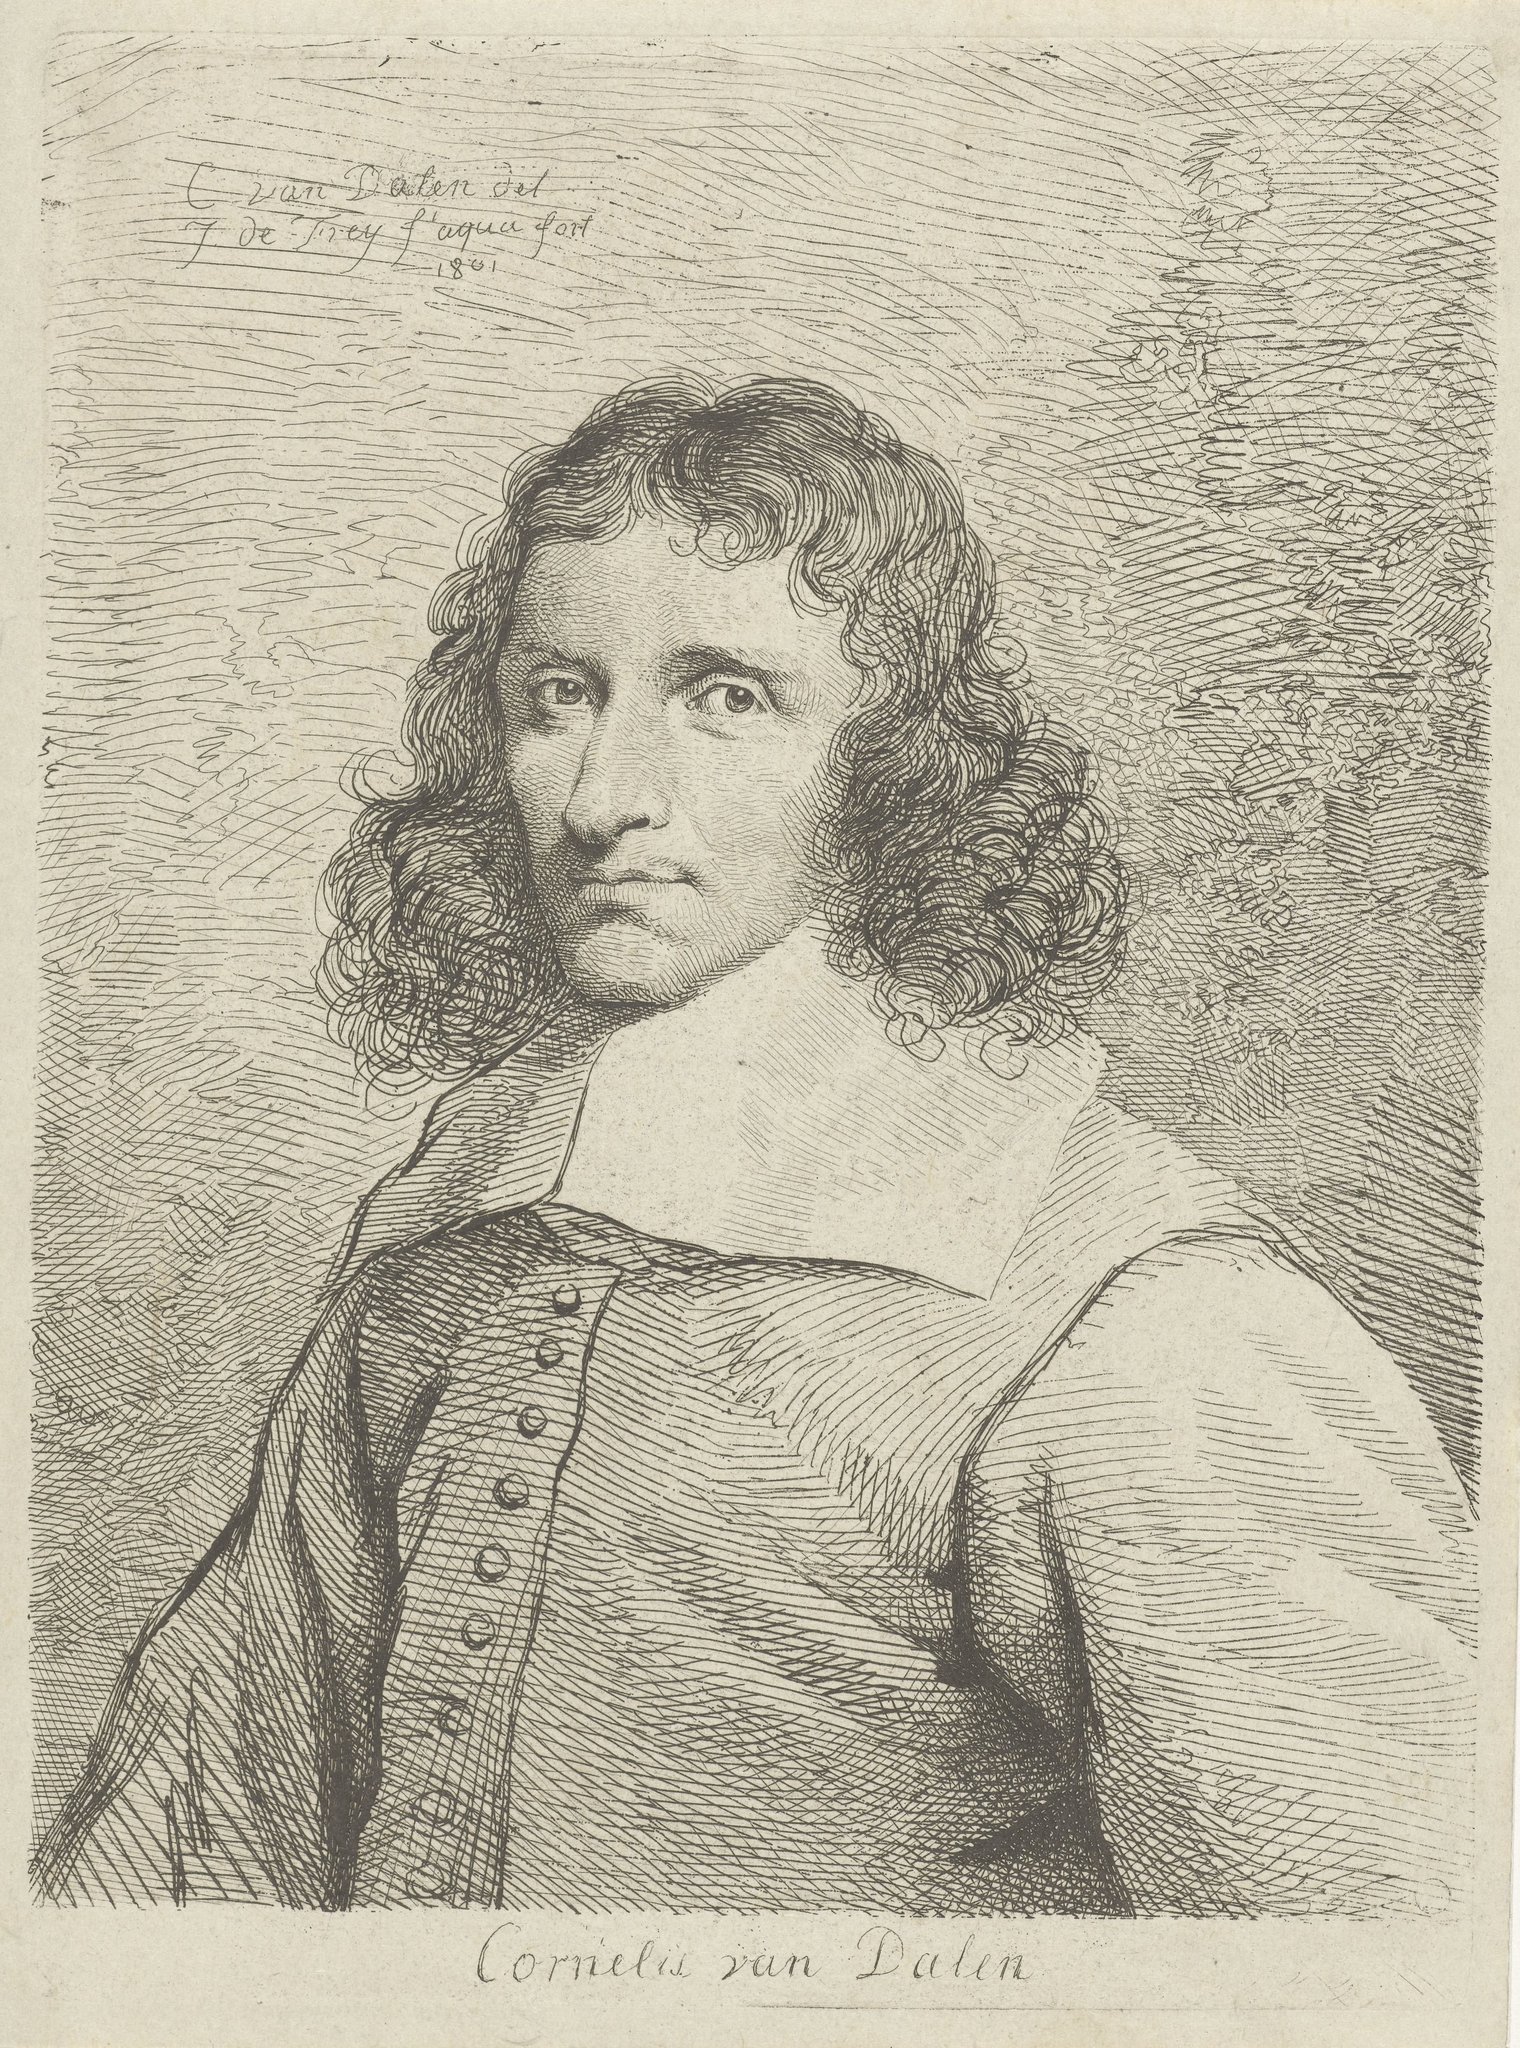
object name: print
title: Portret van Cornelis van Dalen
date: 1801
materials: paper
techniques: etching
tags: cornelis van dalen, portrait, self-portrait of artist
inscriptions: collector's mark: Lugt 2760, collector's mark: Lugt 2228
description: Portret van kunstenaar Cornelis van Dalen, ten halven lijve naar links.